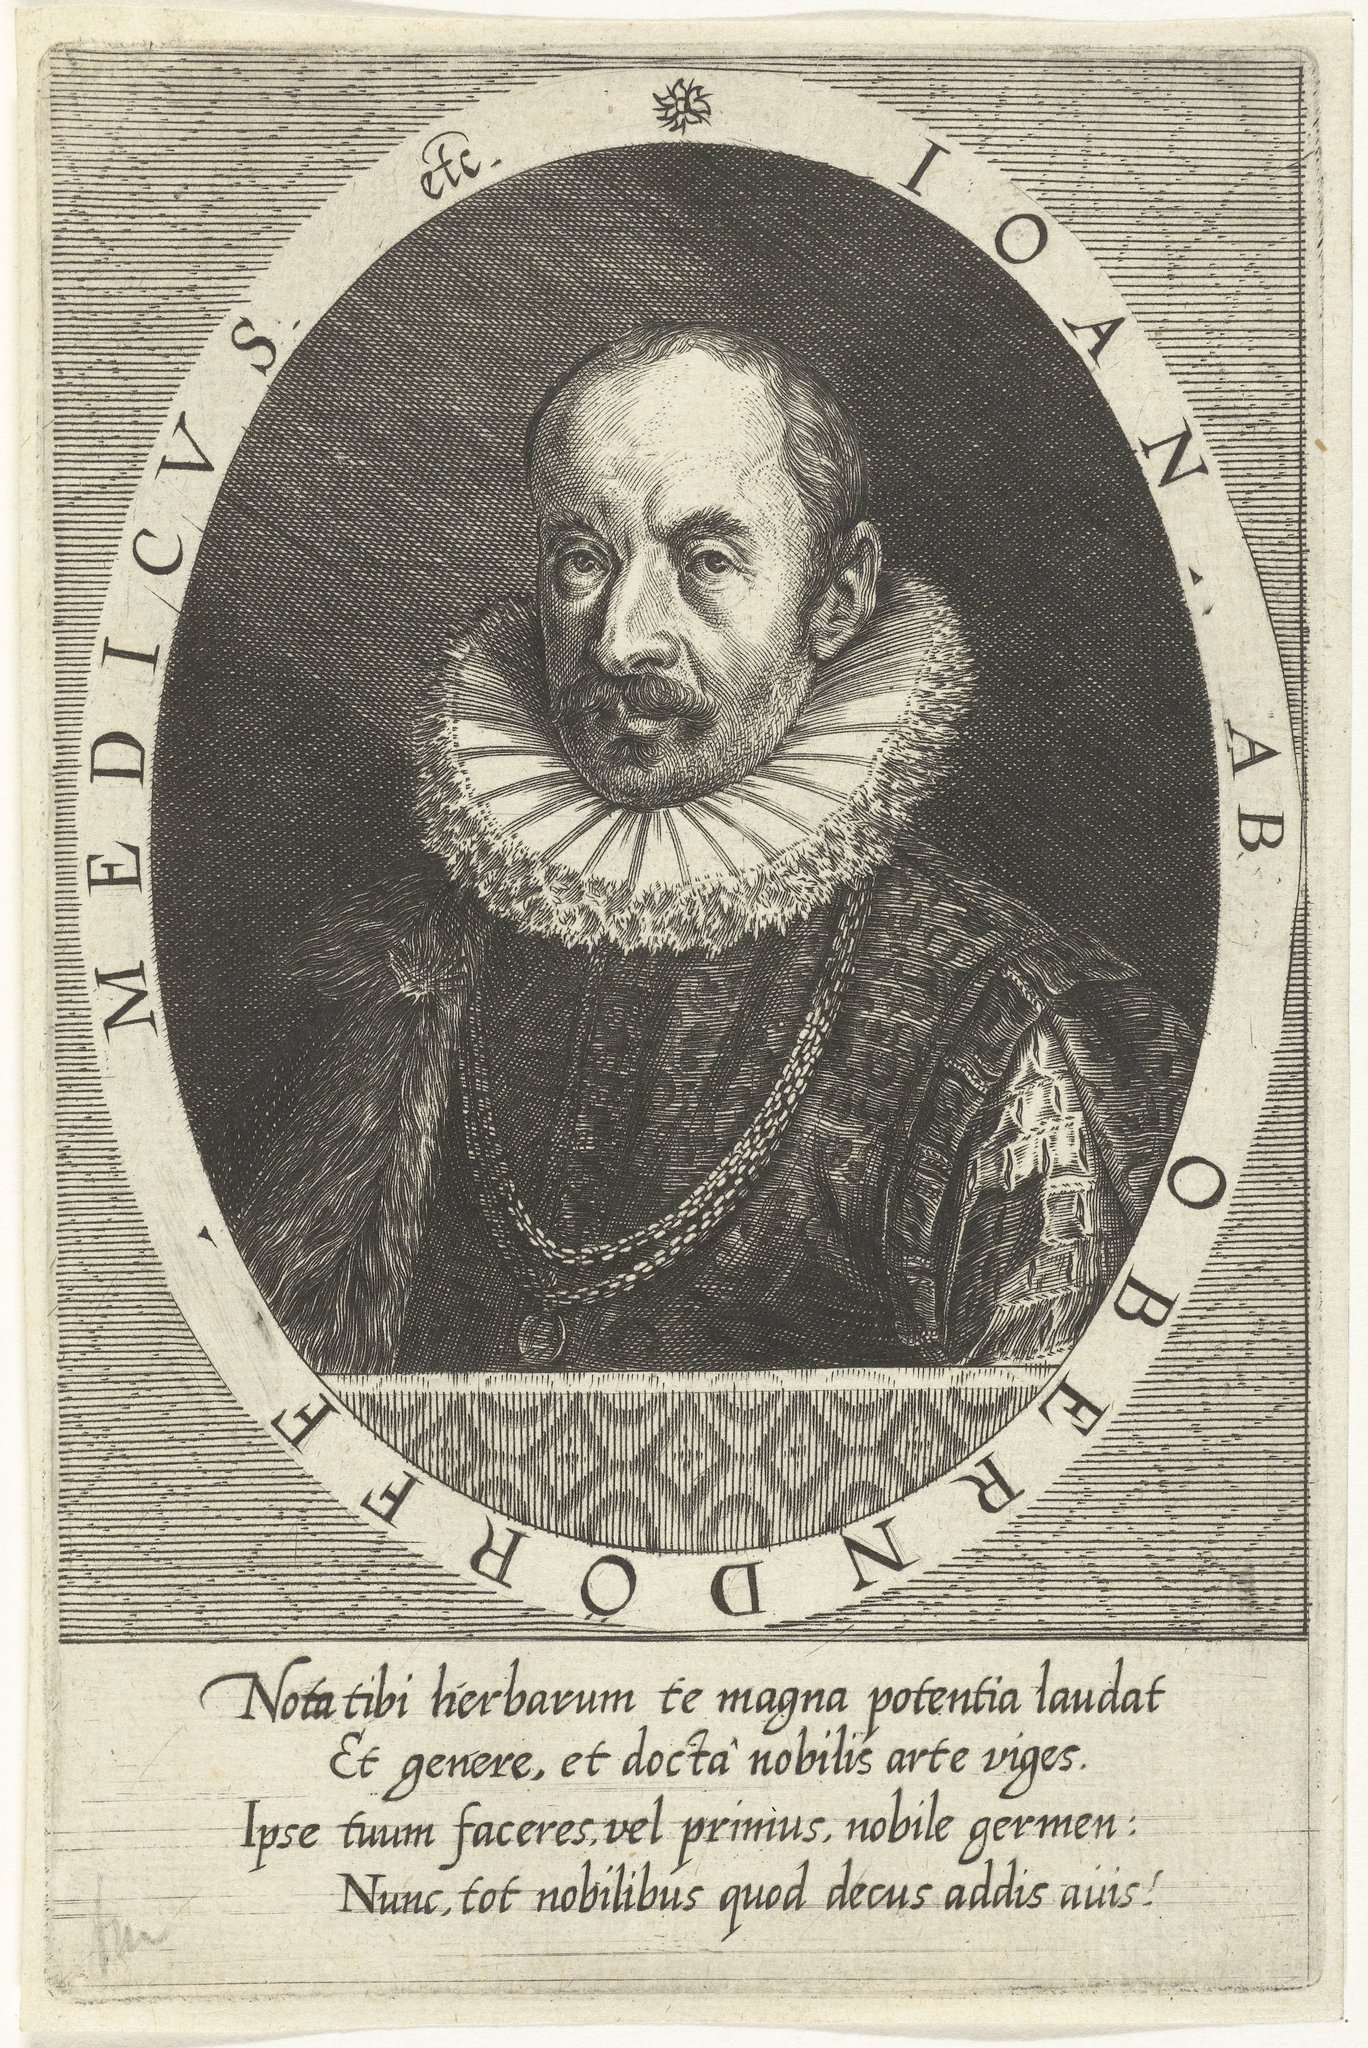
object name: print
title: Atrium Heroicum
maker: dominicus custos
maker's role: print maker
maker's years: 1560-1615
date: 1579-1615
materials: paper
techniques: engraving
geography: augsburg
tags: johan van oberndorf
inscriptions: collector's mark: Lugt 2228